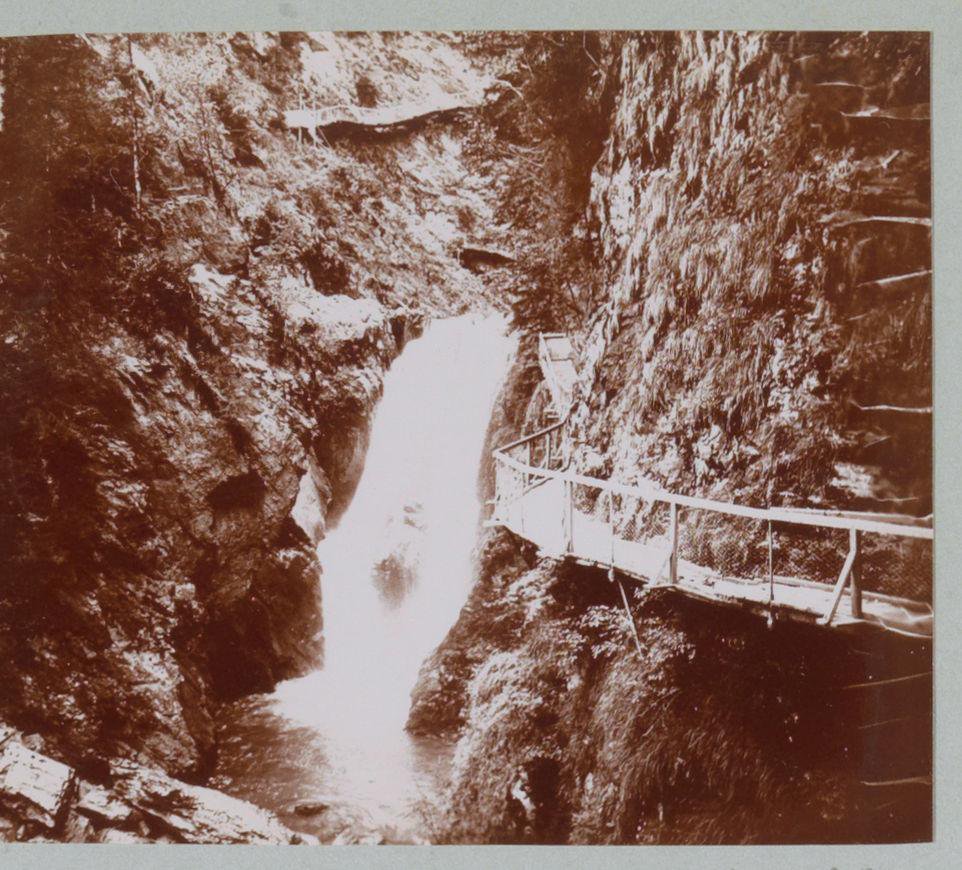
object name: photograph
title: Waterval in de Alpen met bergpad ernaast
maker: Anonymous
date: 1905-1910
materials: paper, photographic support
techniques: gelatin silver print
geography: alps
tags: waterfall, road, path, rock-formations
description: Onderdeel van Fotoalbum van een Franse amateurfotograaf met bezienswaardigheden in Frankrijk, Zwitserland en Italië.